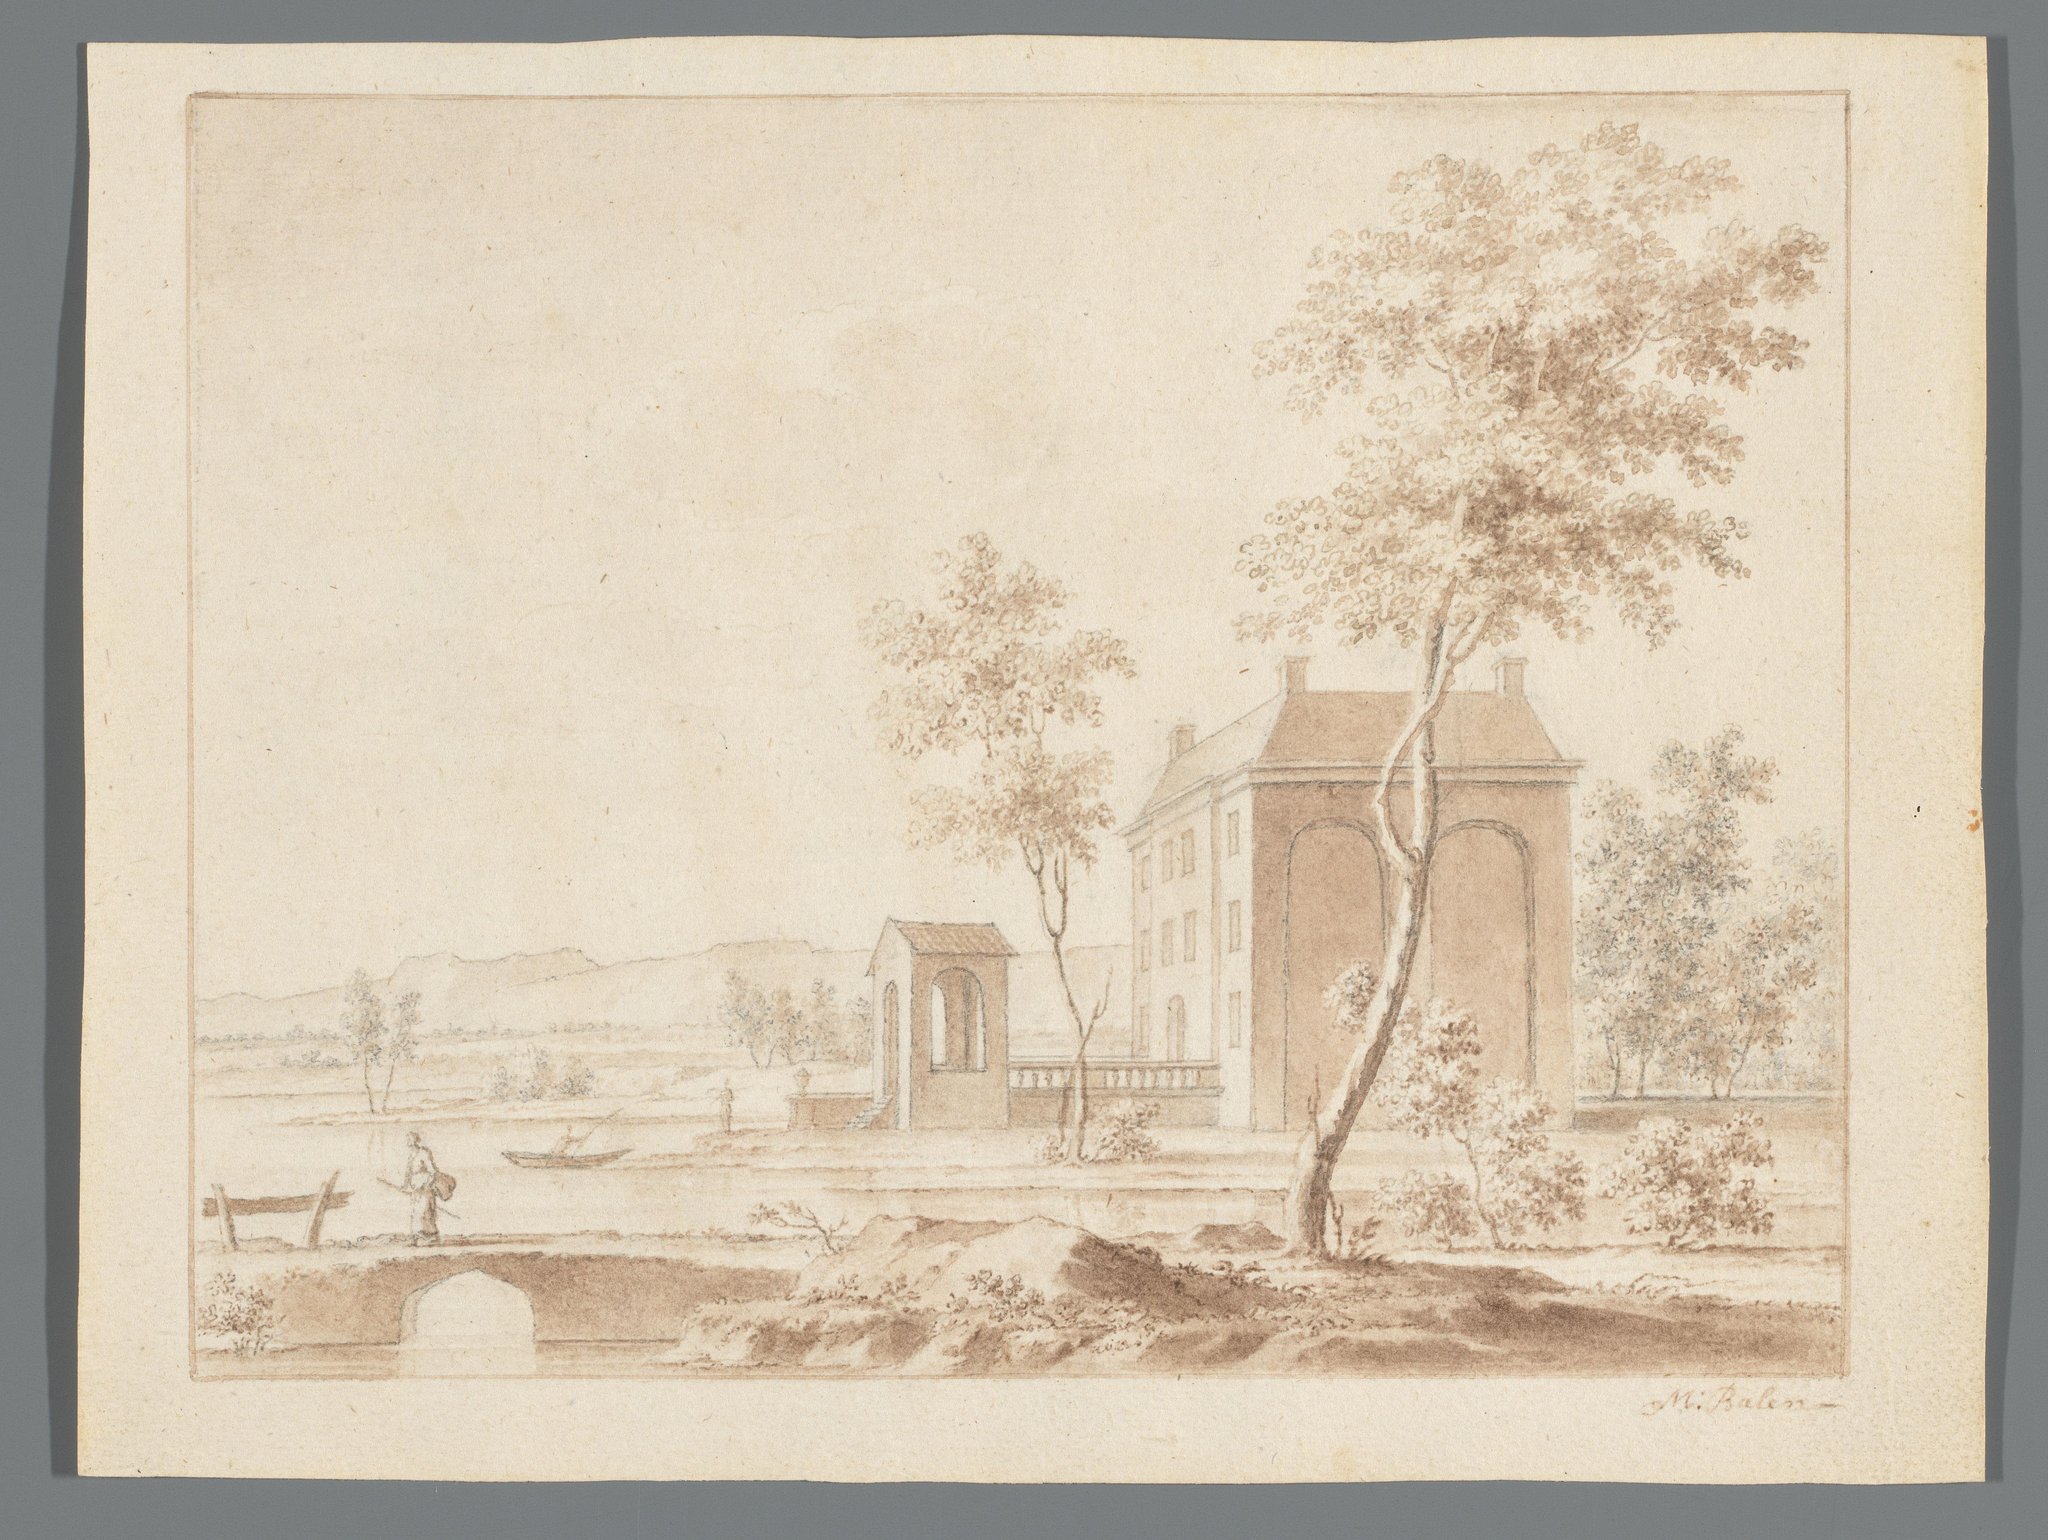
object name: drawing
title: Rivierlandschap met gebouw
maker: matthijs balen (1684-1766)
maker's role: draughtsman, painter, print maker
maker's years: 1684-1766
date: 1694-1766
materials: paper, pencil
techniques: brush, pen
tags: city-view, and landscape with man-made constructions, rural housing, e.g. country-house, villa, cottage